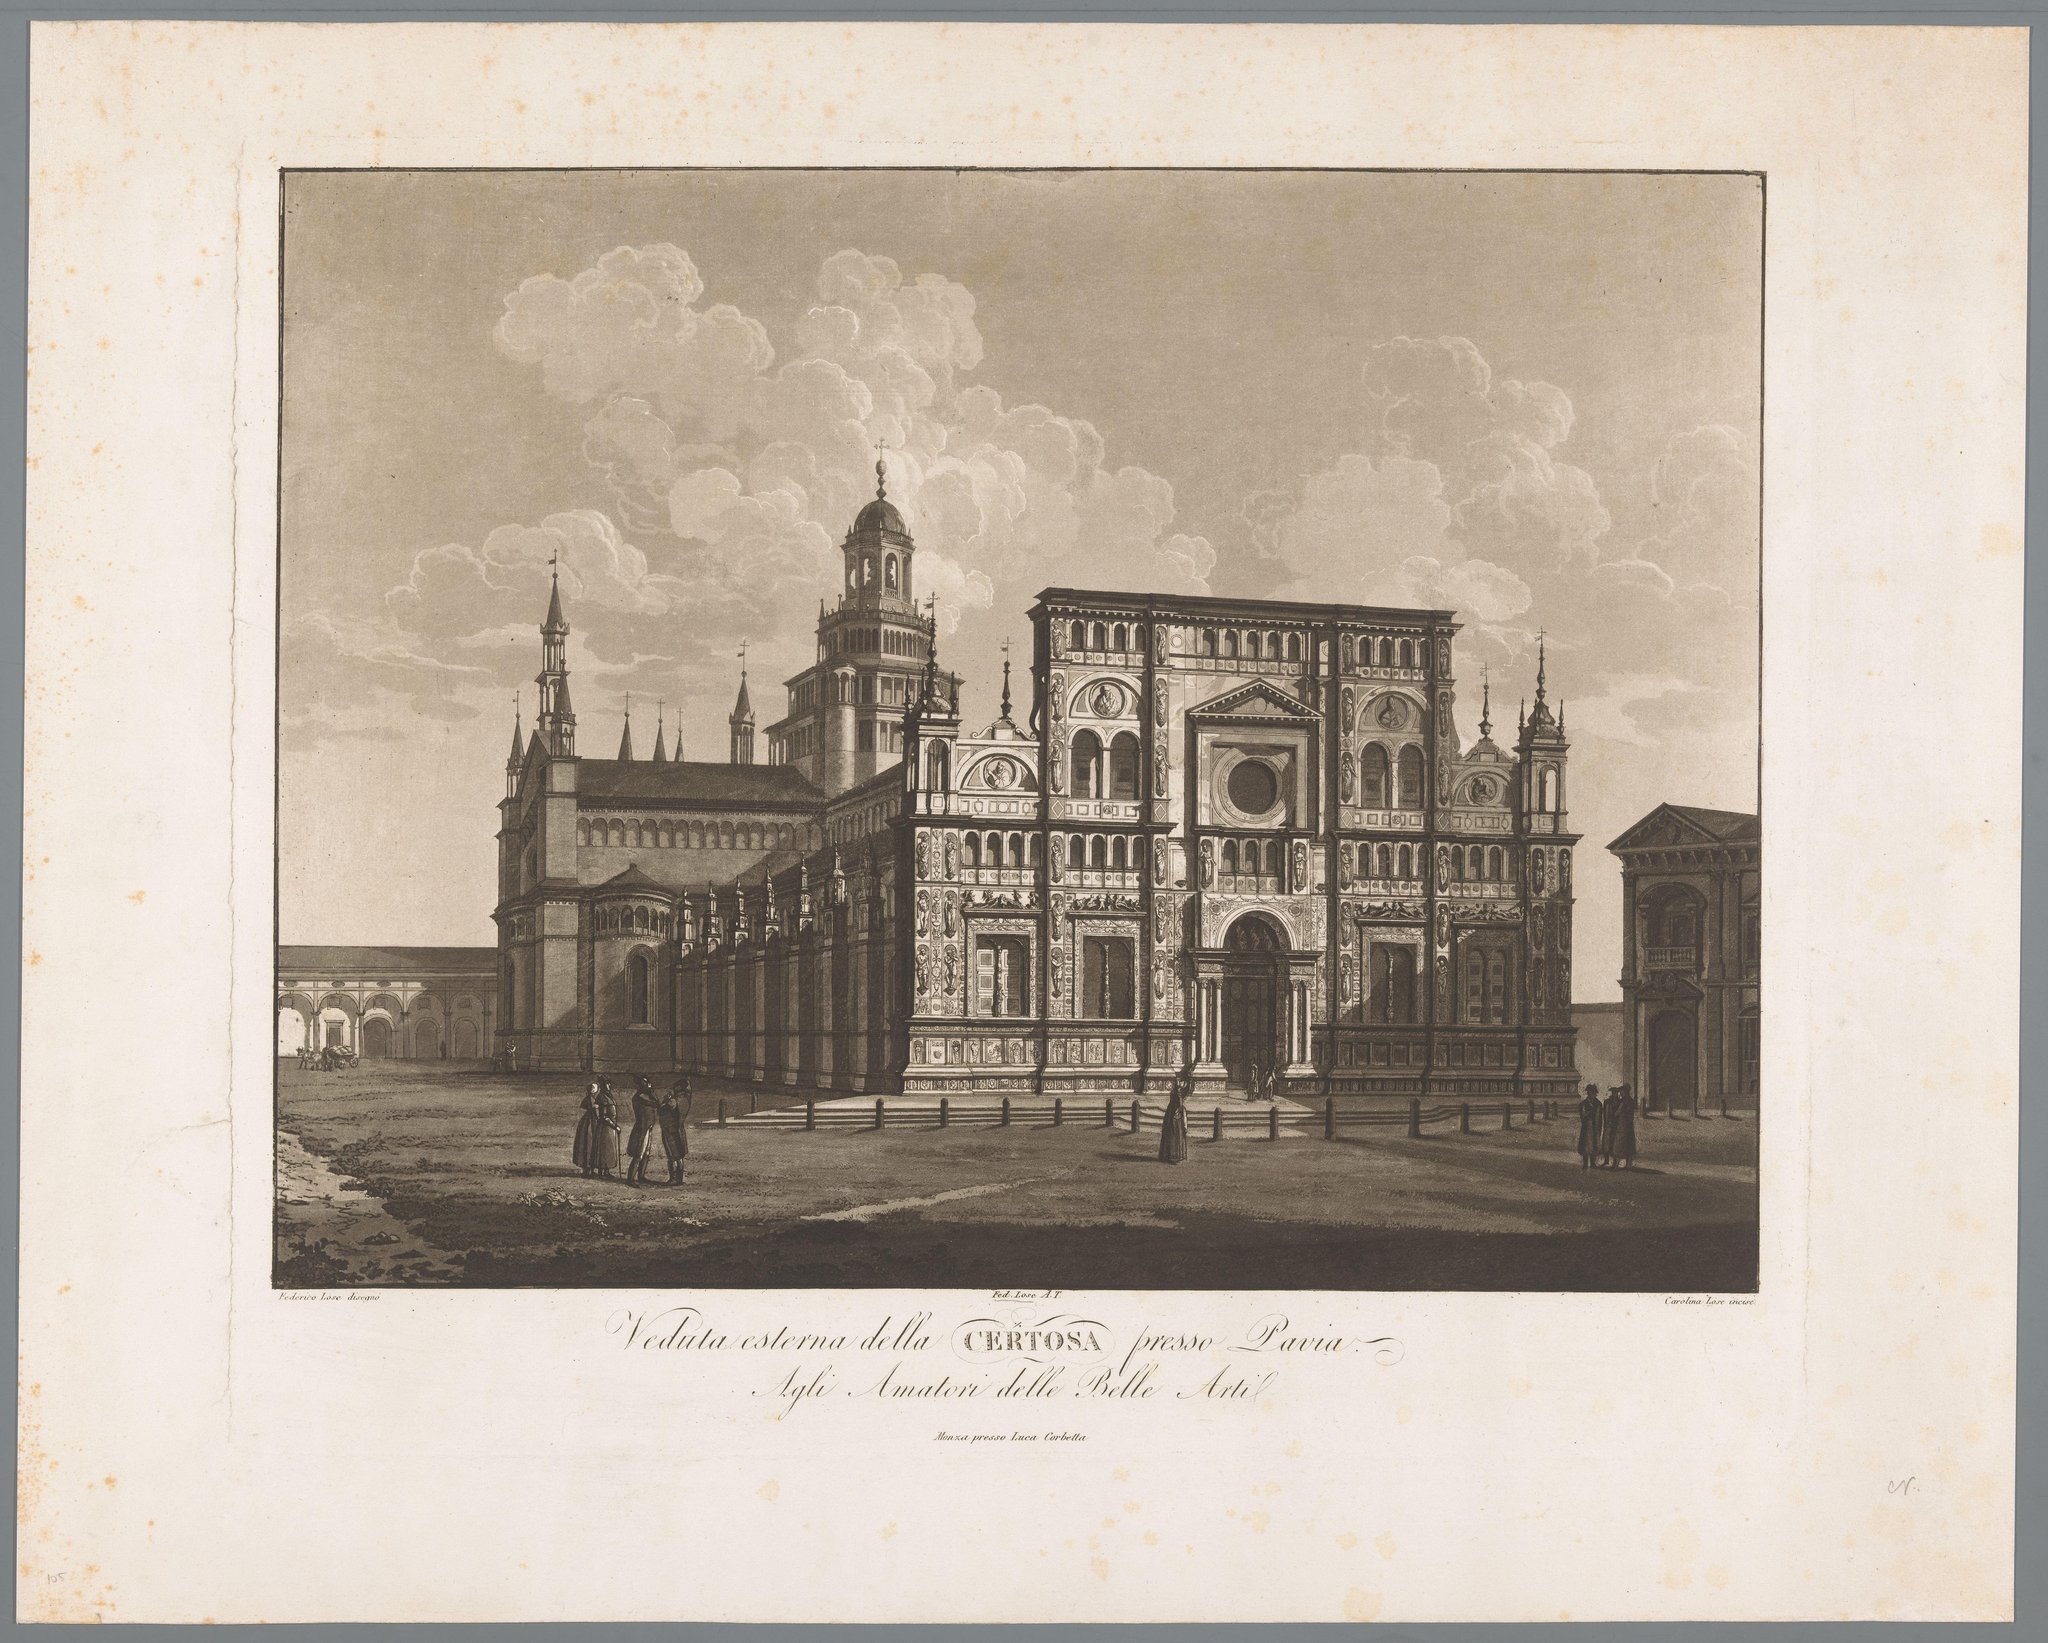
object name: print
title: Gezicht op de Certosa van Padula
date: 1786-1850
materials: paper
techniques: aquatint, etching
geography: monza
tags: church (exterior)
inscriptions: collector's mark: Lugt 2228